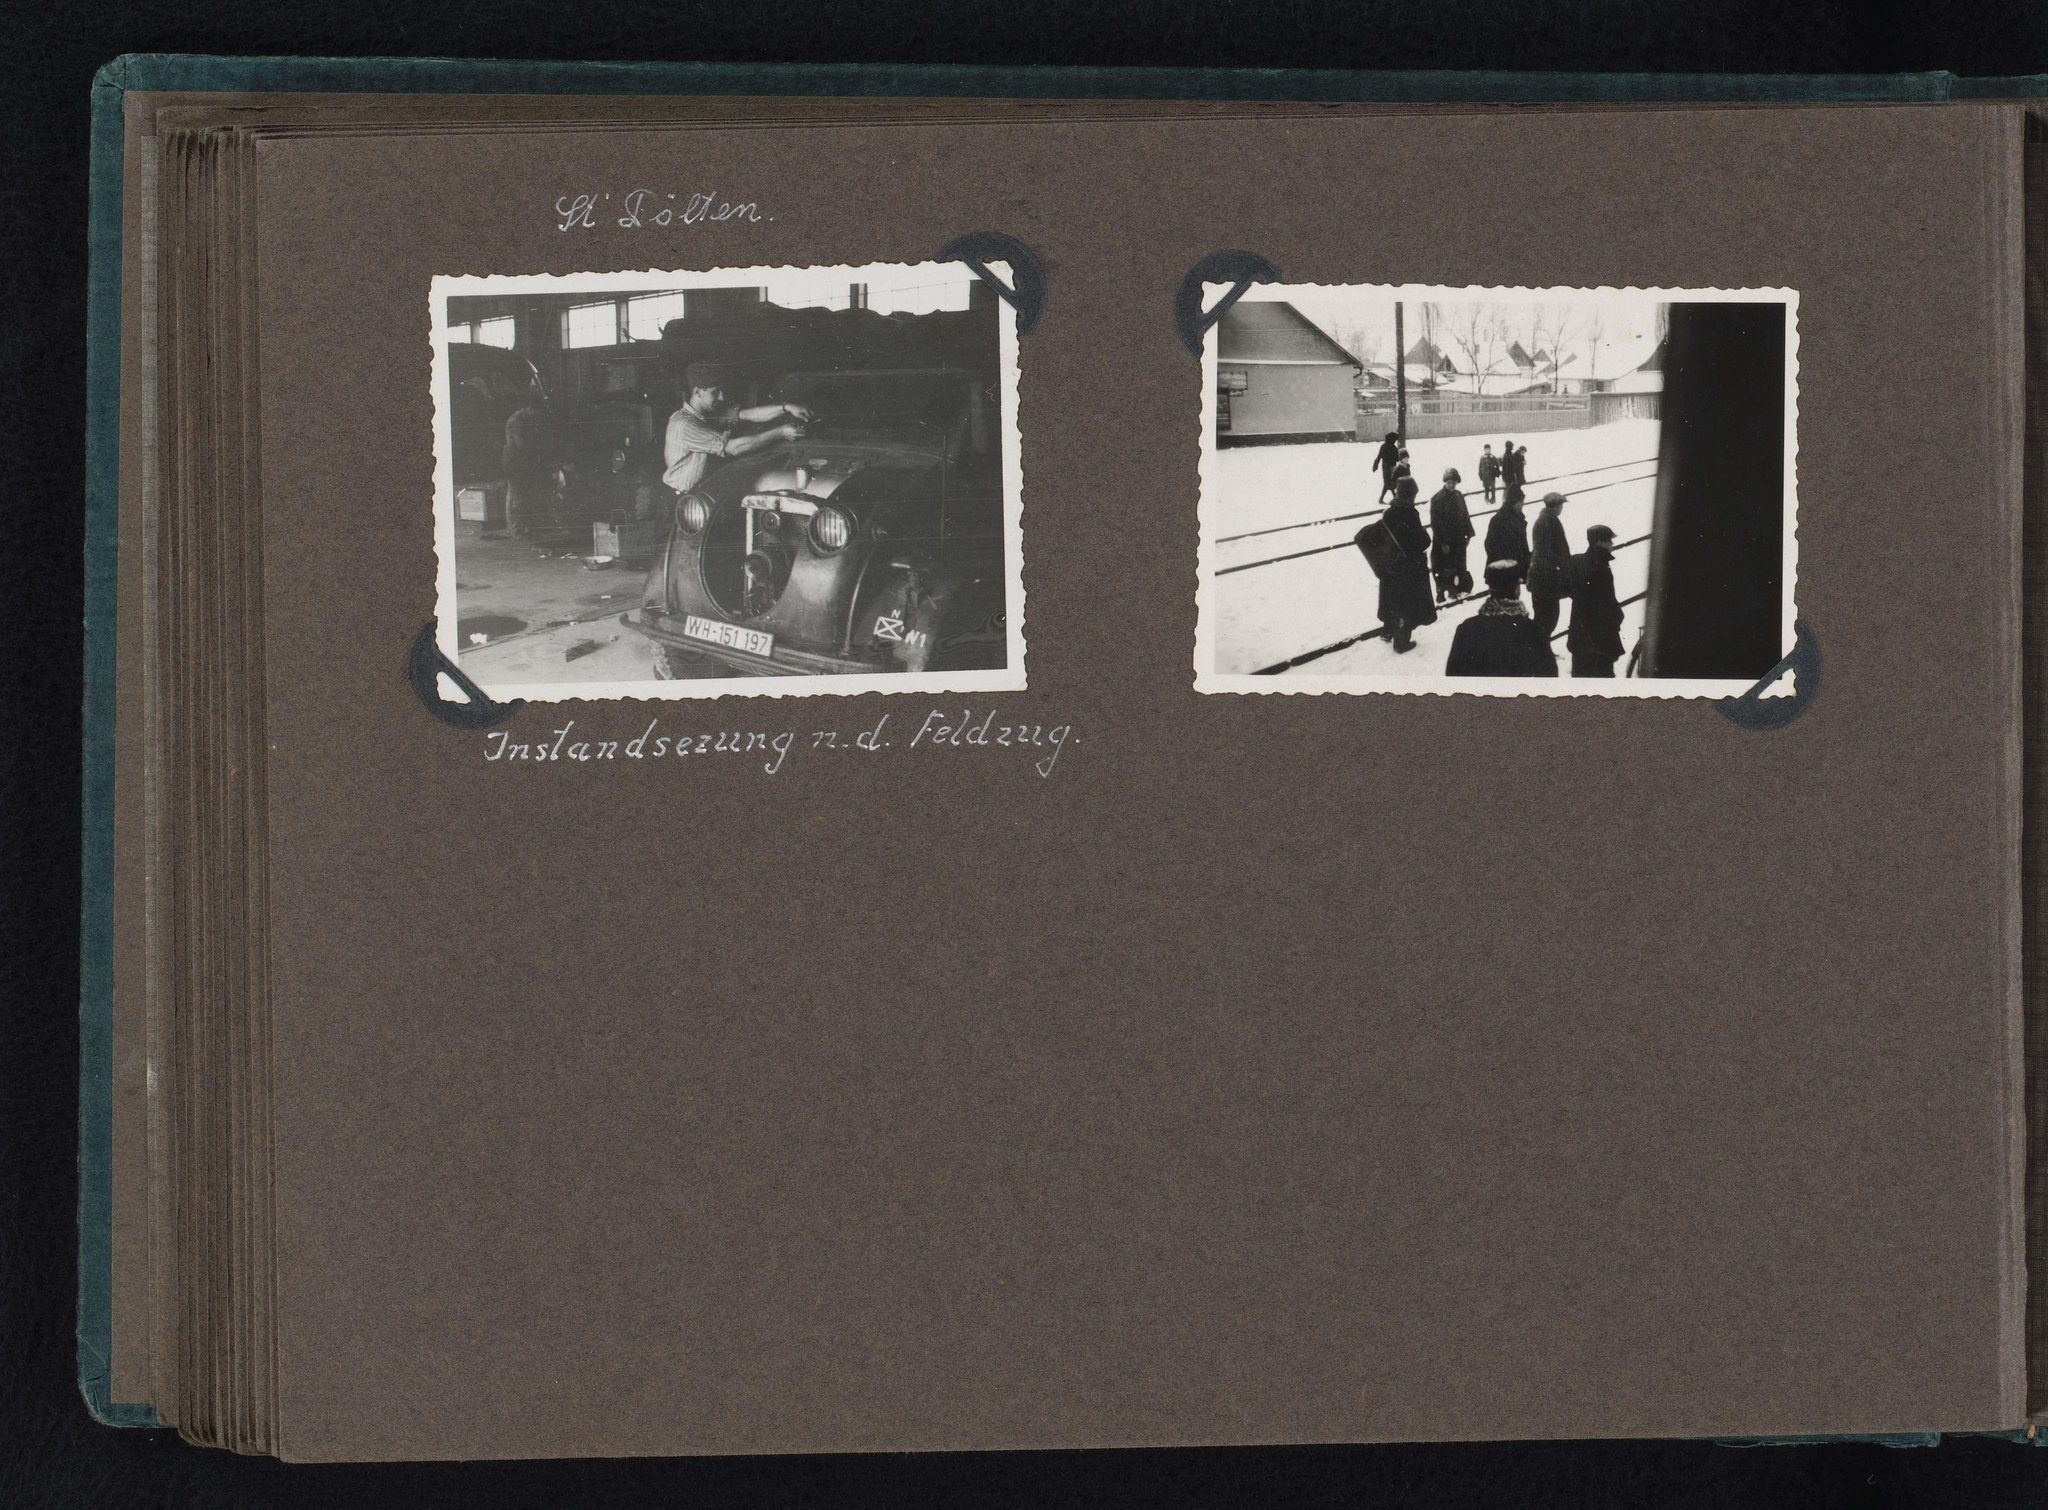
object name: album leaf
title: Sankt Pölten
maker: Anonymous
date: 1940-1945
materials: cardboard, photographic support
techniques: gelatin silver print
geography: austria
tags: repair shop, garage for repairs, supplies etc., the soldier; the soldier's life, austria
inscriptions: inscription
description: Albumblad met twee foto's in Sankt Pölten, Oostenrijk. Onderdeel van het fotoalbum 'Kriegserinnerungen' 1940-1945.